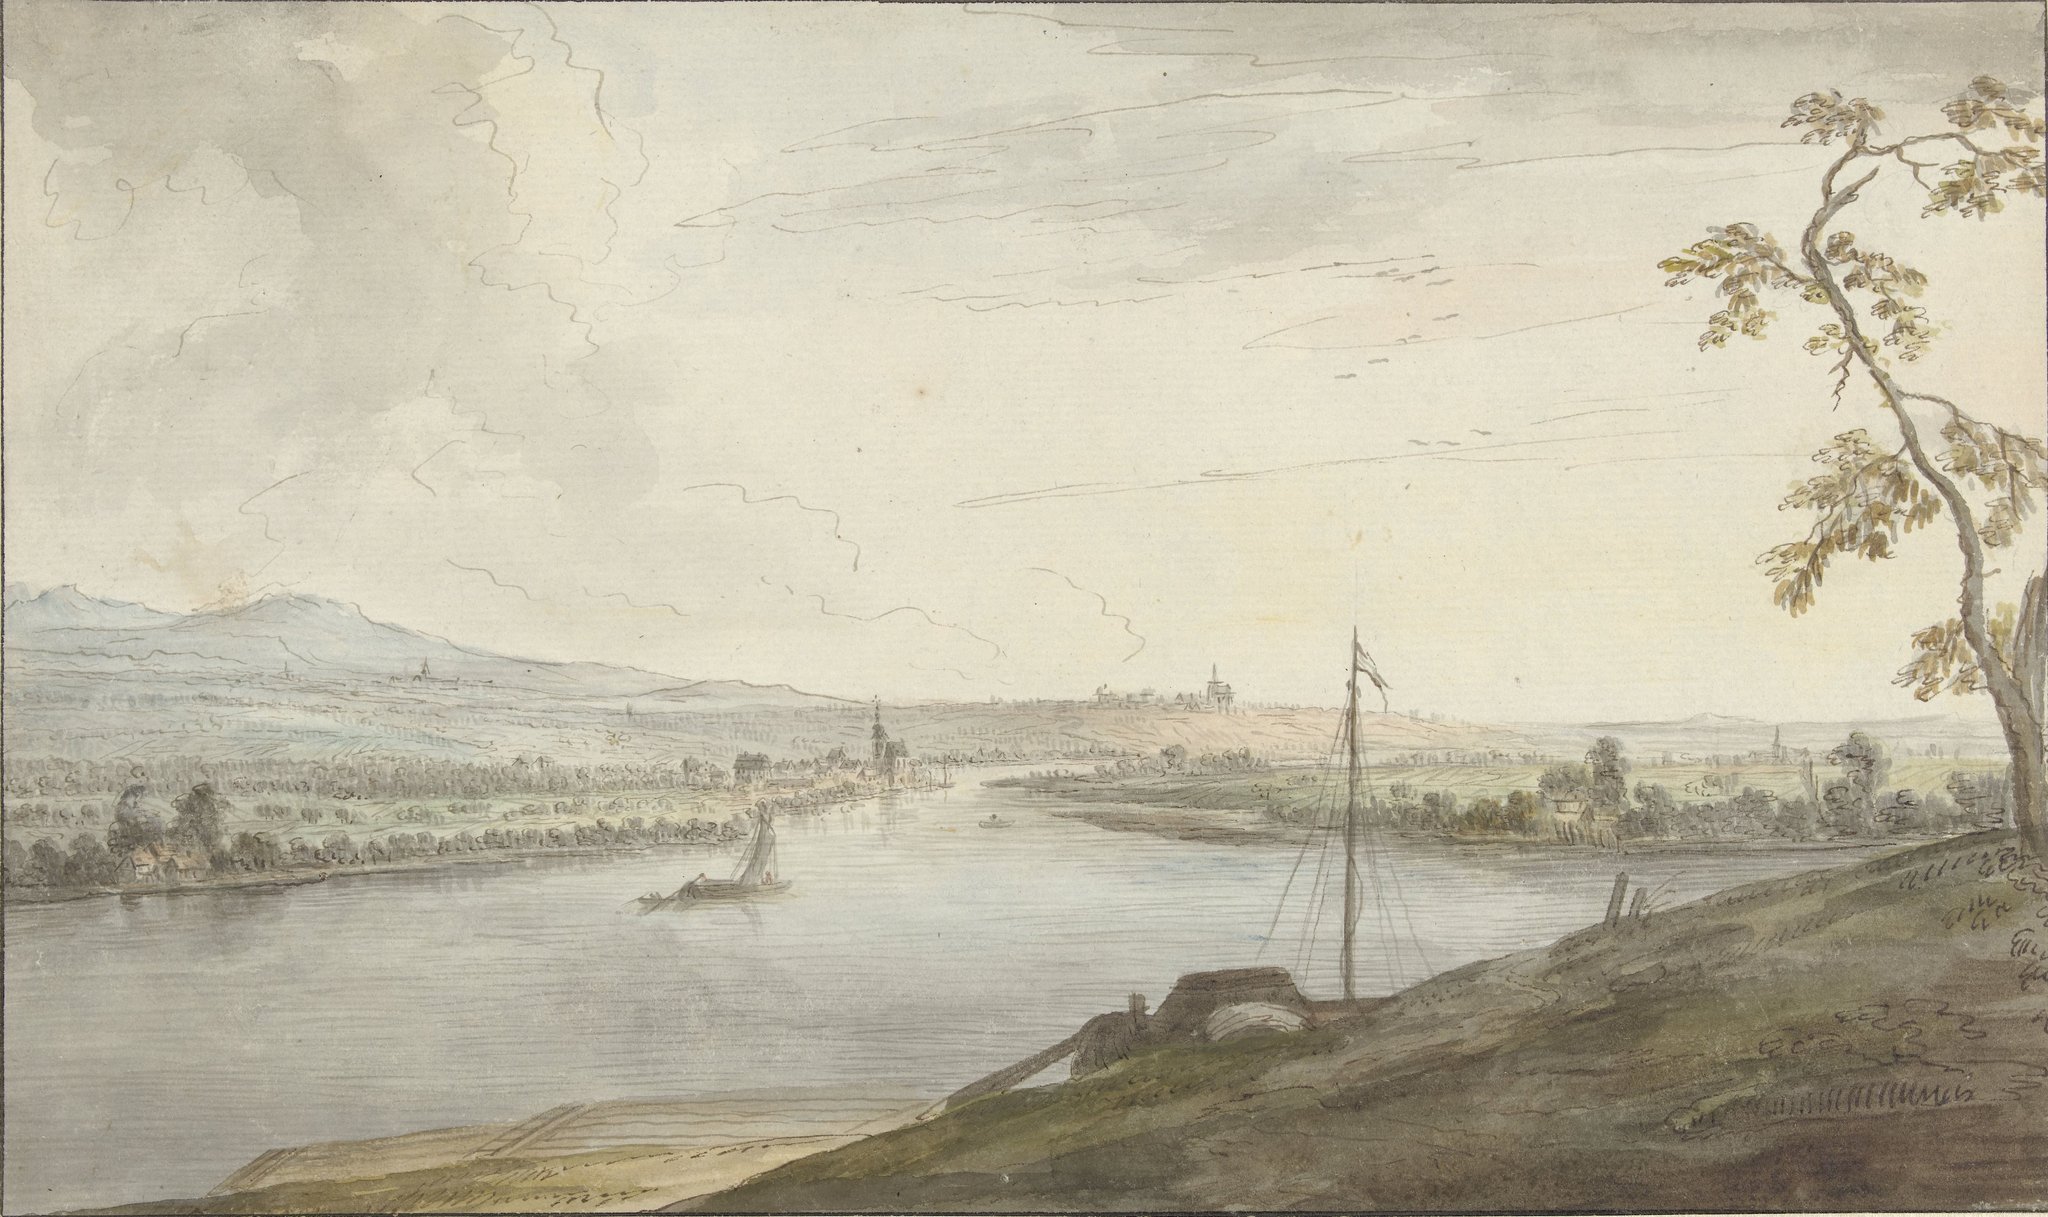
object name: drawing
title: Riviergezicht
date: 1740-1797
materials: ink, paper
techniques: brush, pen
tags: river (+ landscape with figures, staffage)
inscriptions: annotation: ‘Kerkheim’